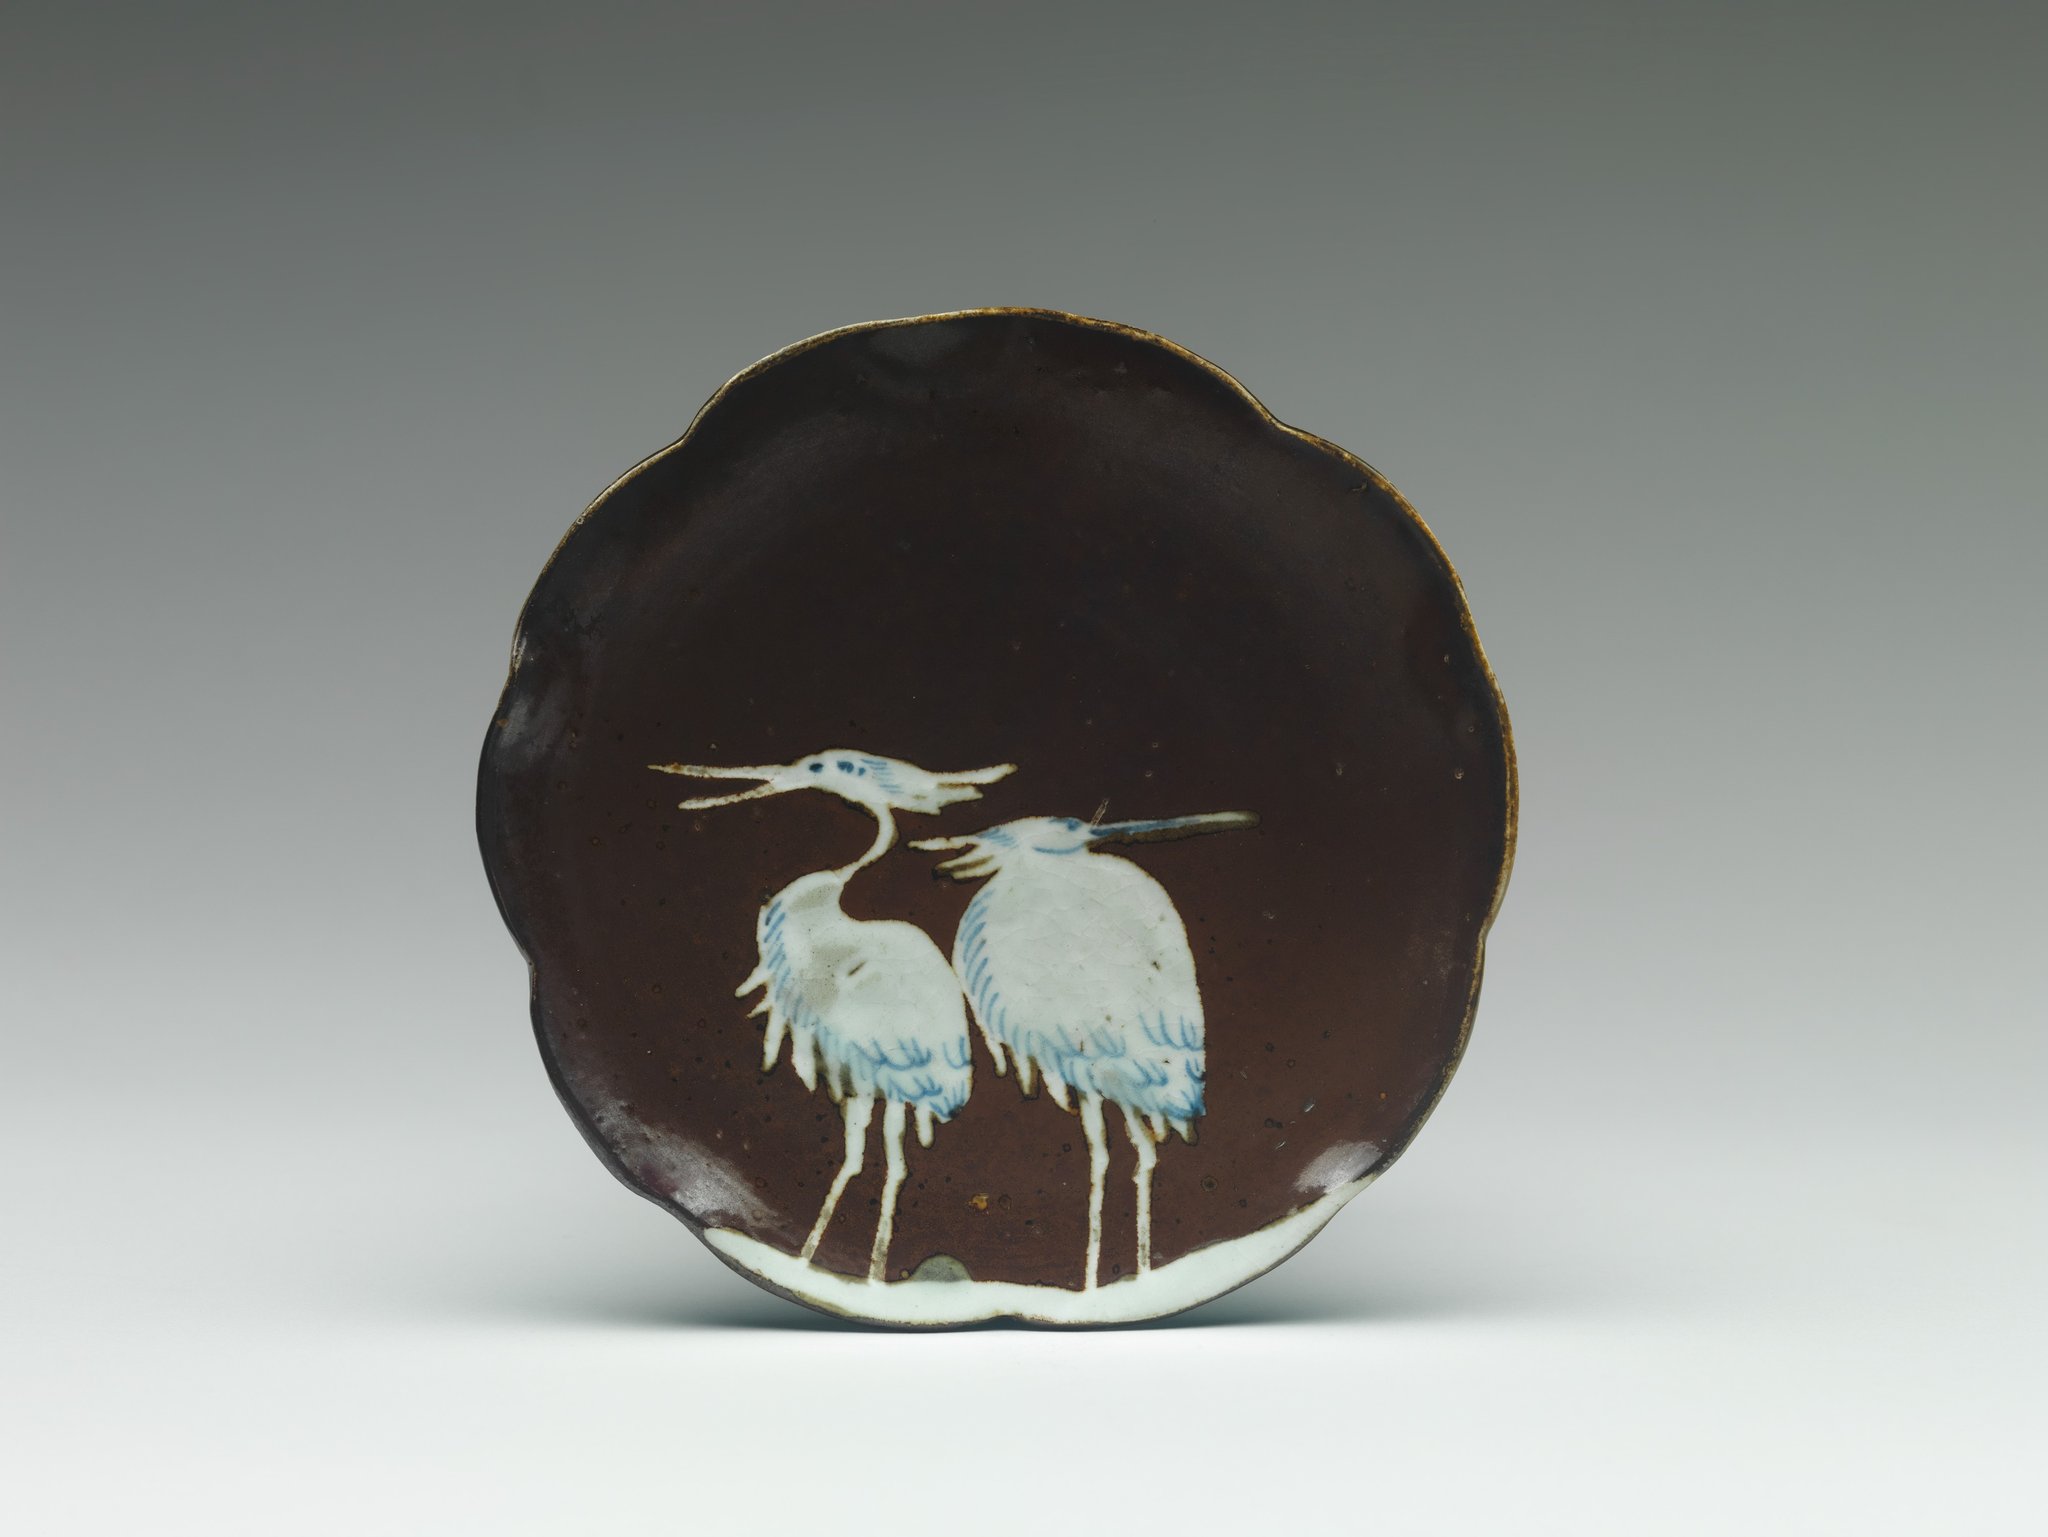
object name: plate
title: Plate with Decoration of Two Cranes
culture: japanese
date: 1615-1868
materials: glaze, iron, porcelain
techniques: underglaze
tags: cranes